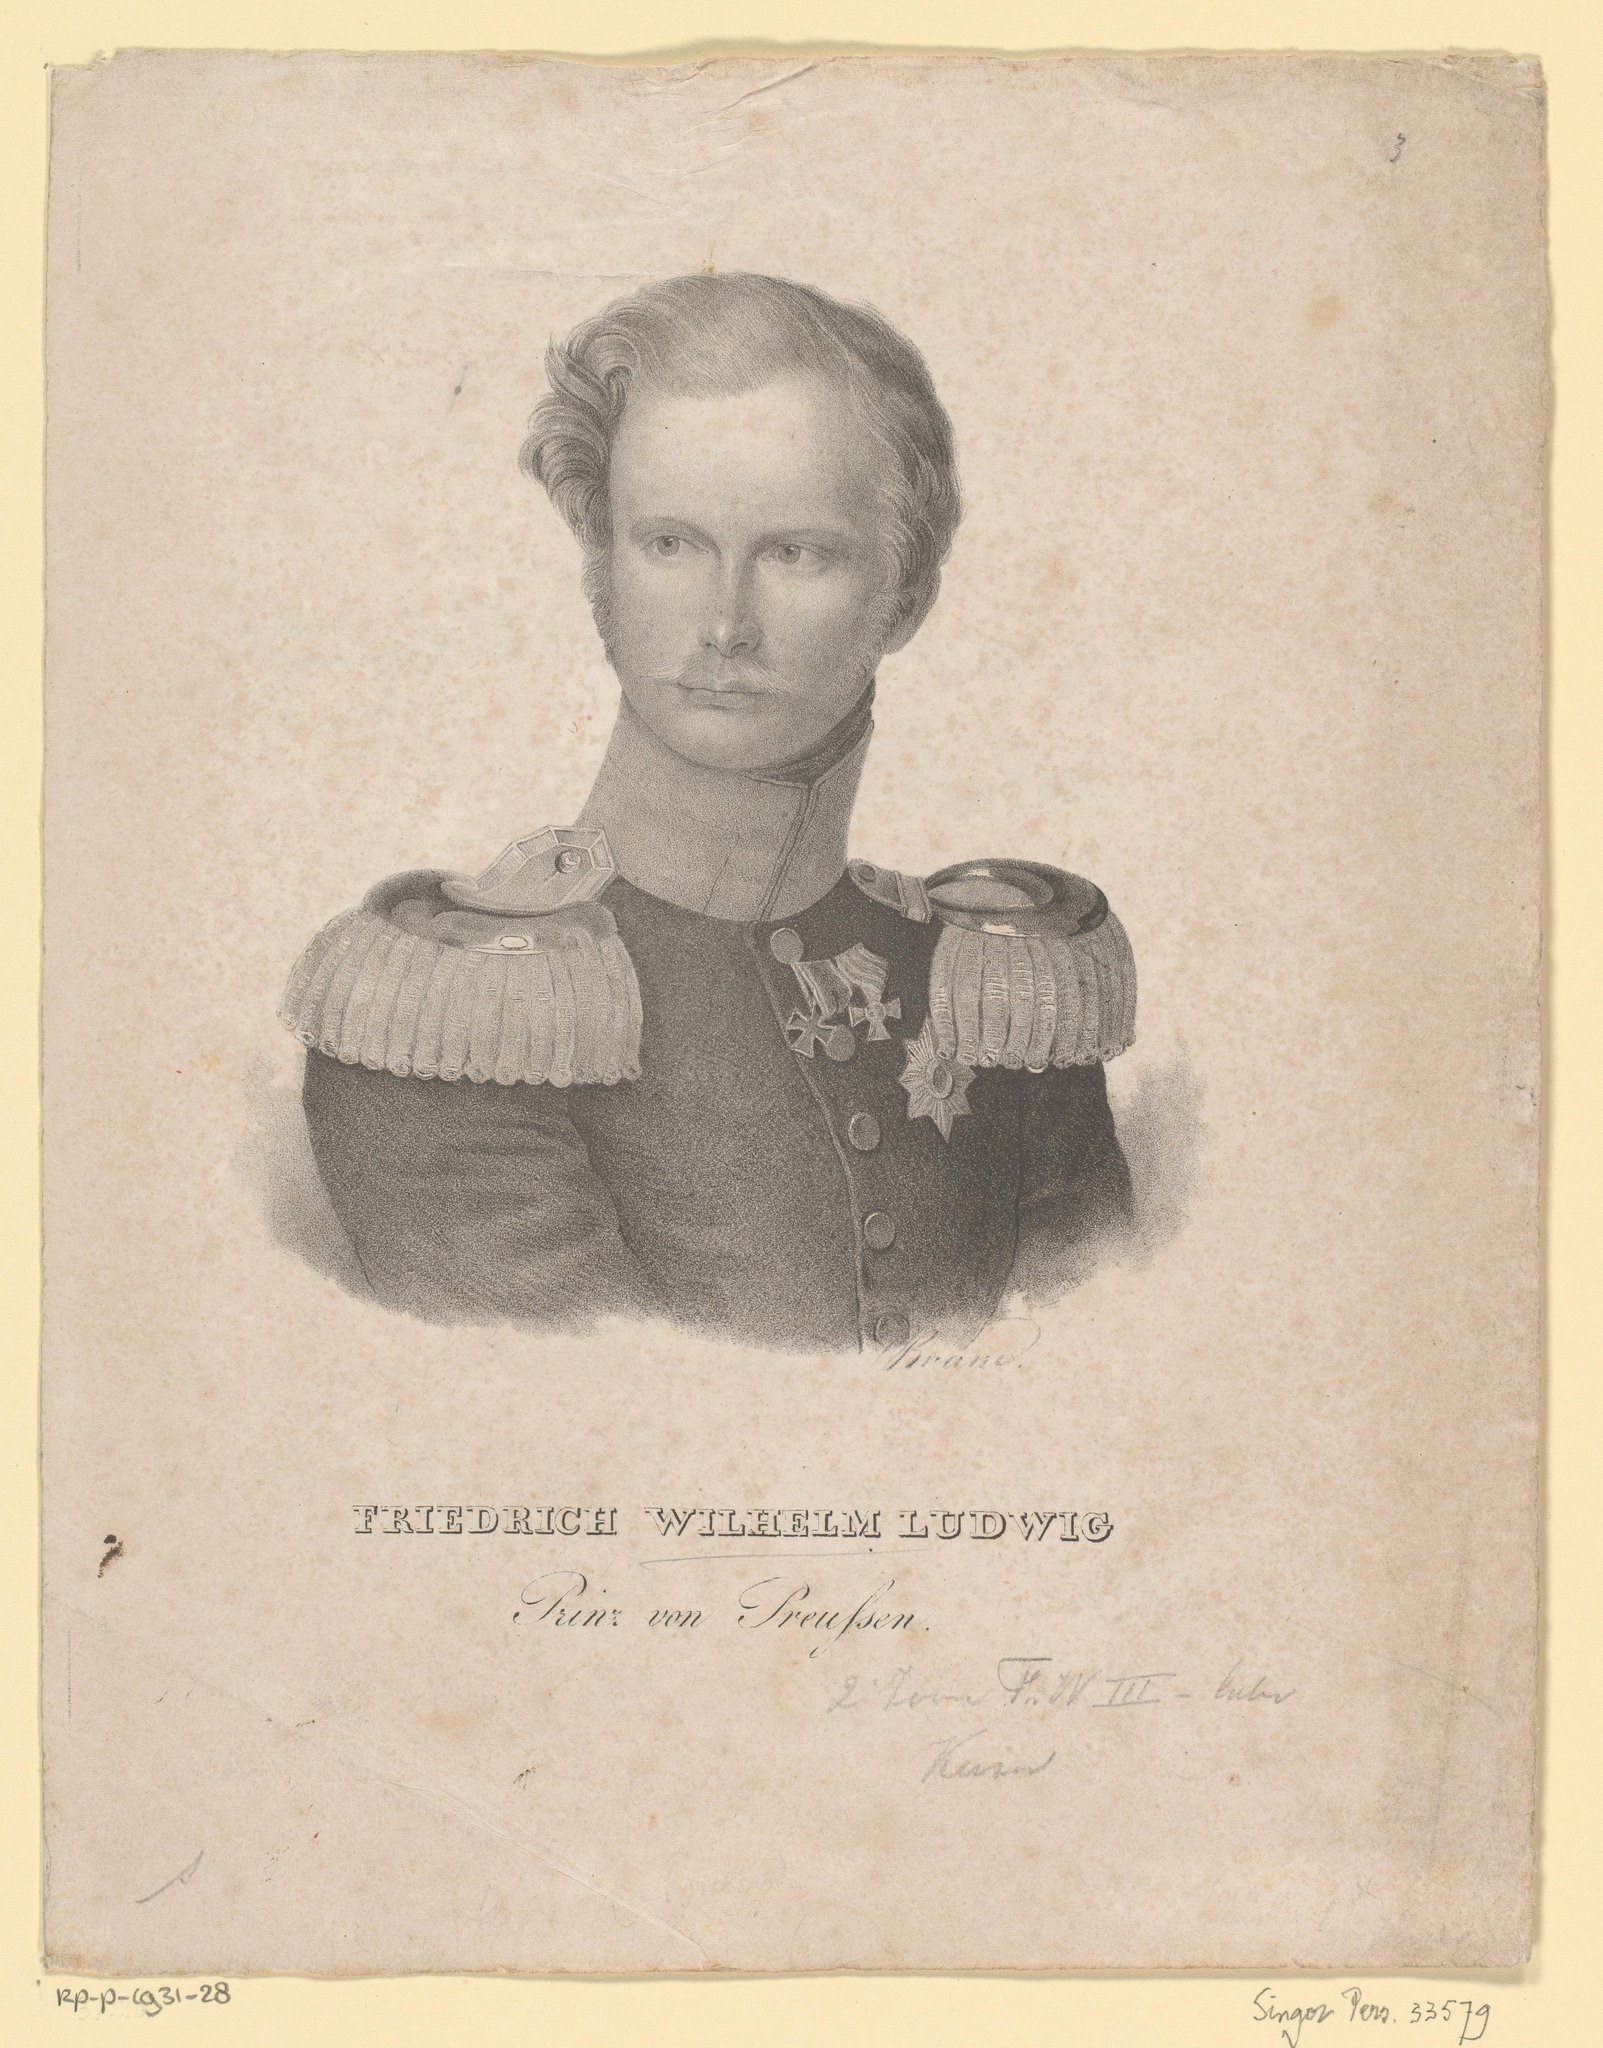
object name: print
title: Friedrich Wilhelm Ludwig Prinz von Preussen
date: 1824-1852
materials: paper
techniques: lithograph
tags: berlin, wilhelm i (keizer van duitsland), historical persons, ranks ~ rulers, sovereigns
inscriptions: collector's mark: Lugt 5327, signature: ‘Brand.’